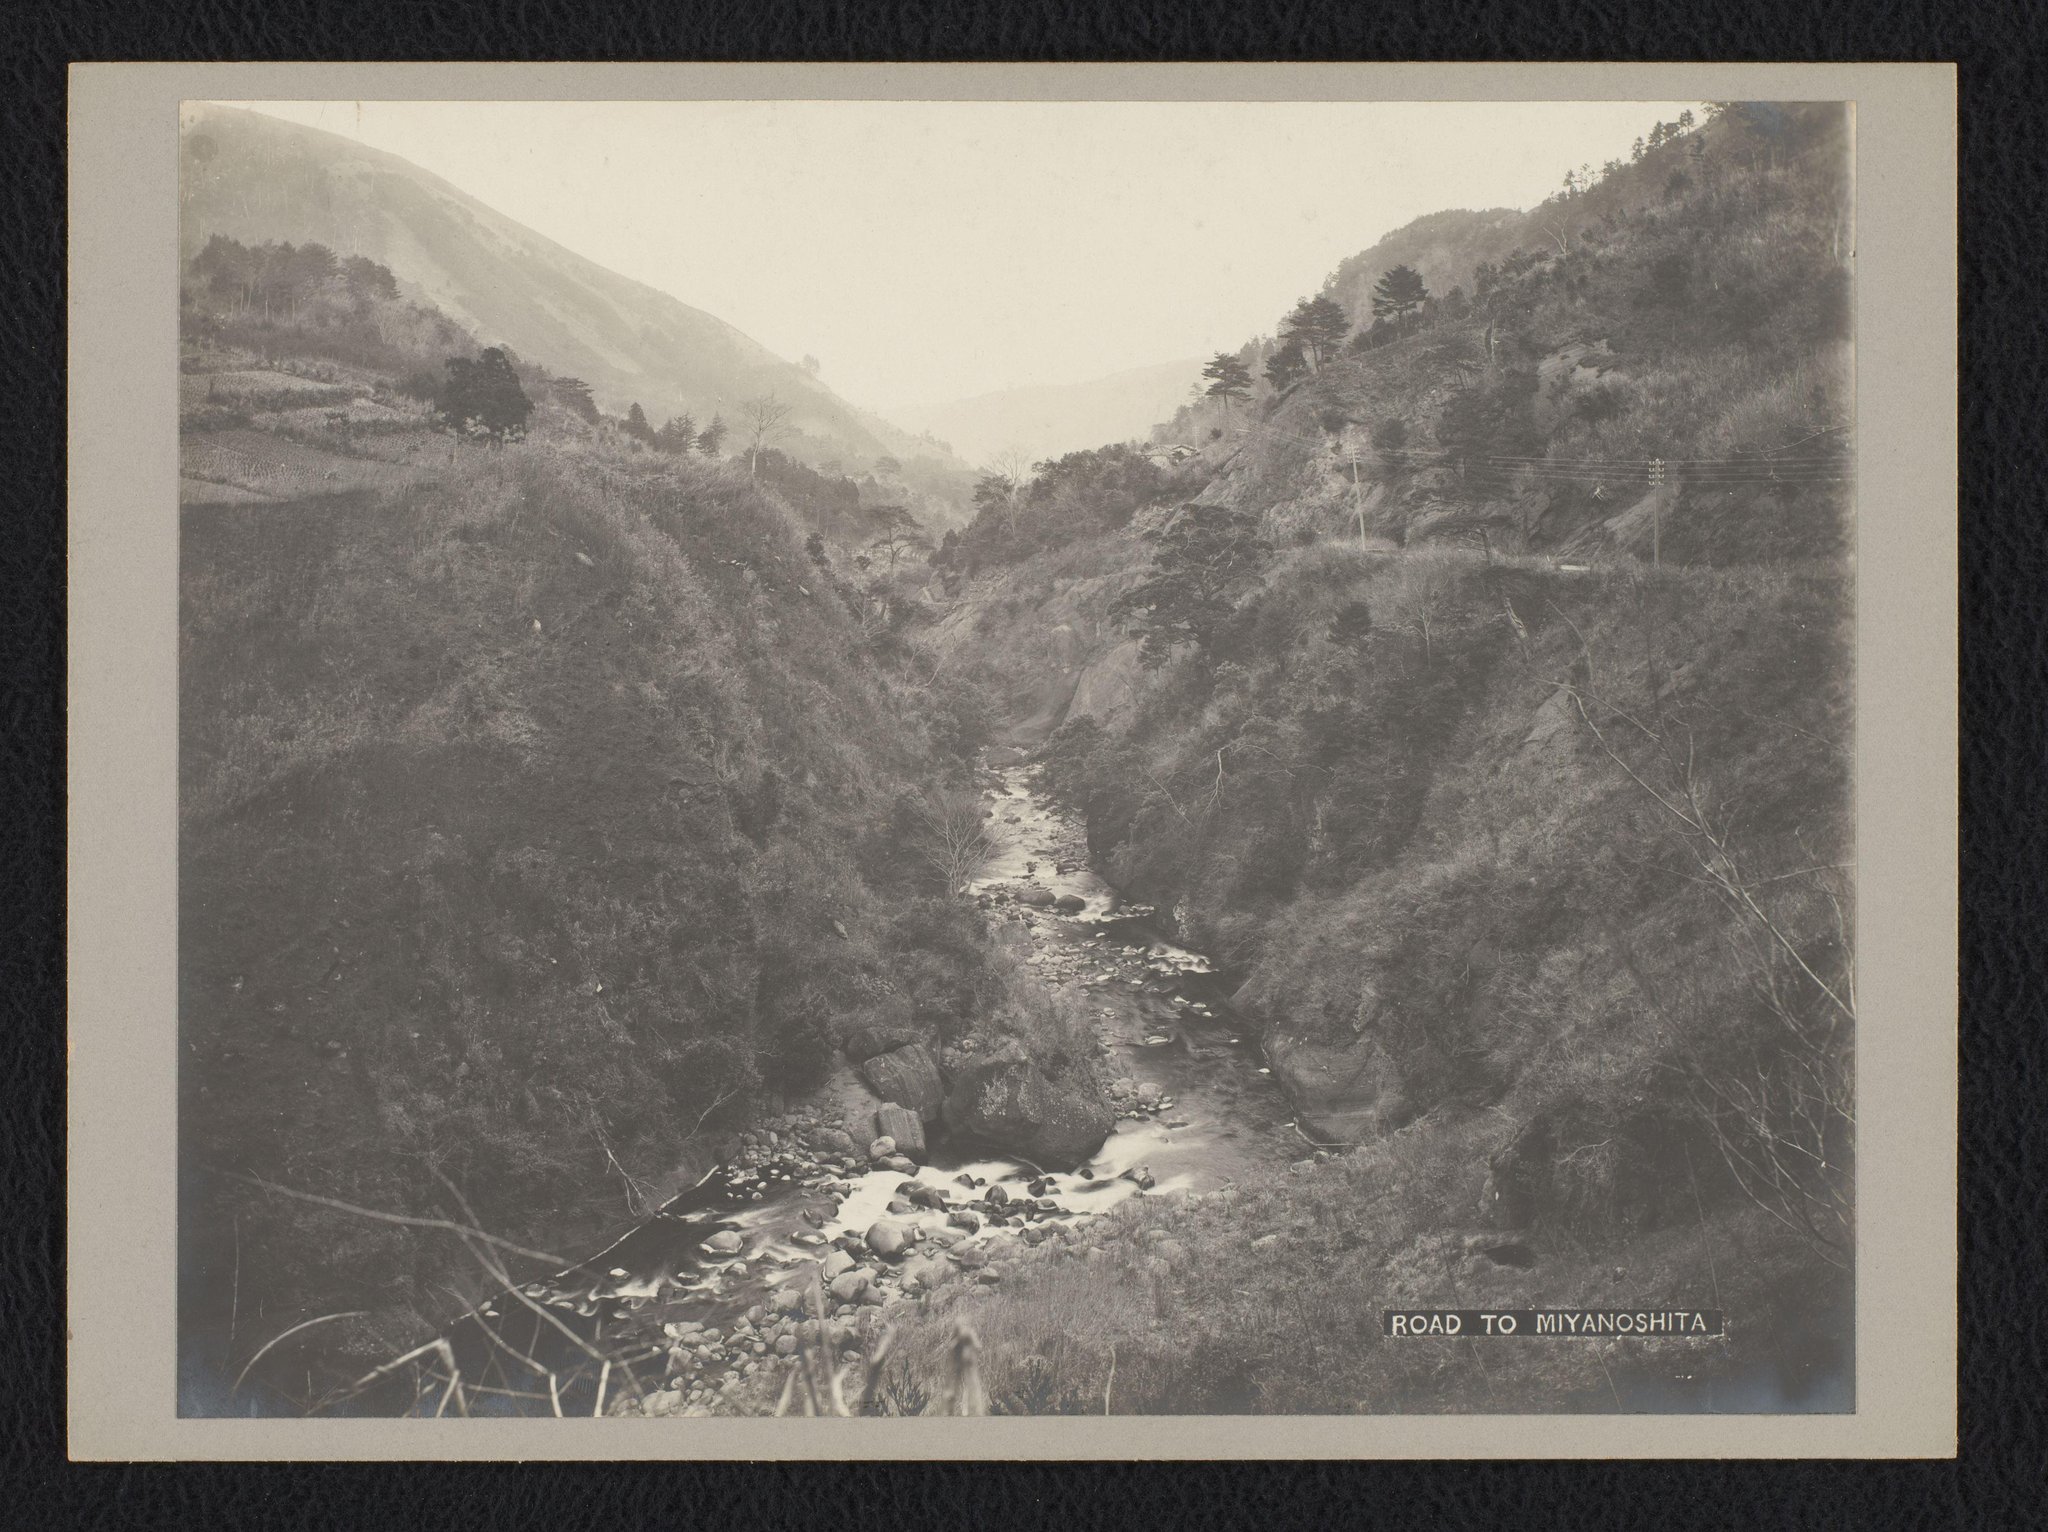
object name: photograph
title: Road to Miyanoshita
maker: Anonymous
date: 1895-1915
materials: cardboard, photographic support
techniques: gelatin silver print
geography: kanagawa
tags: kanagawa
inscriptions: number: ‘16.’